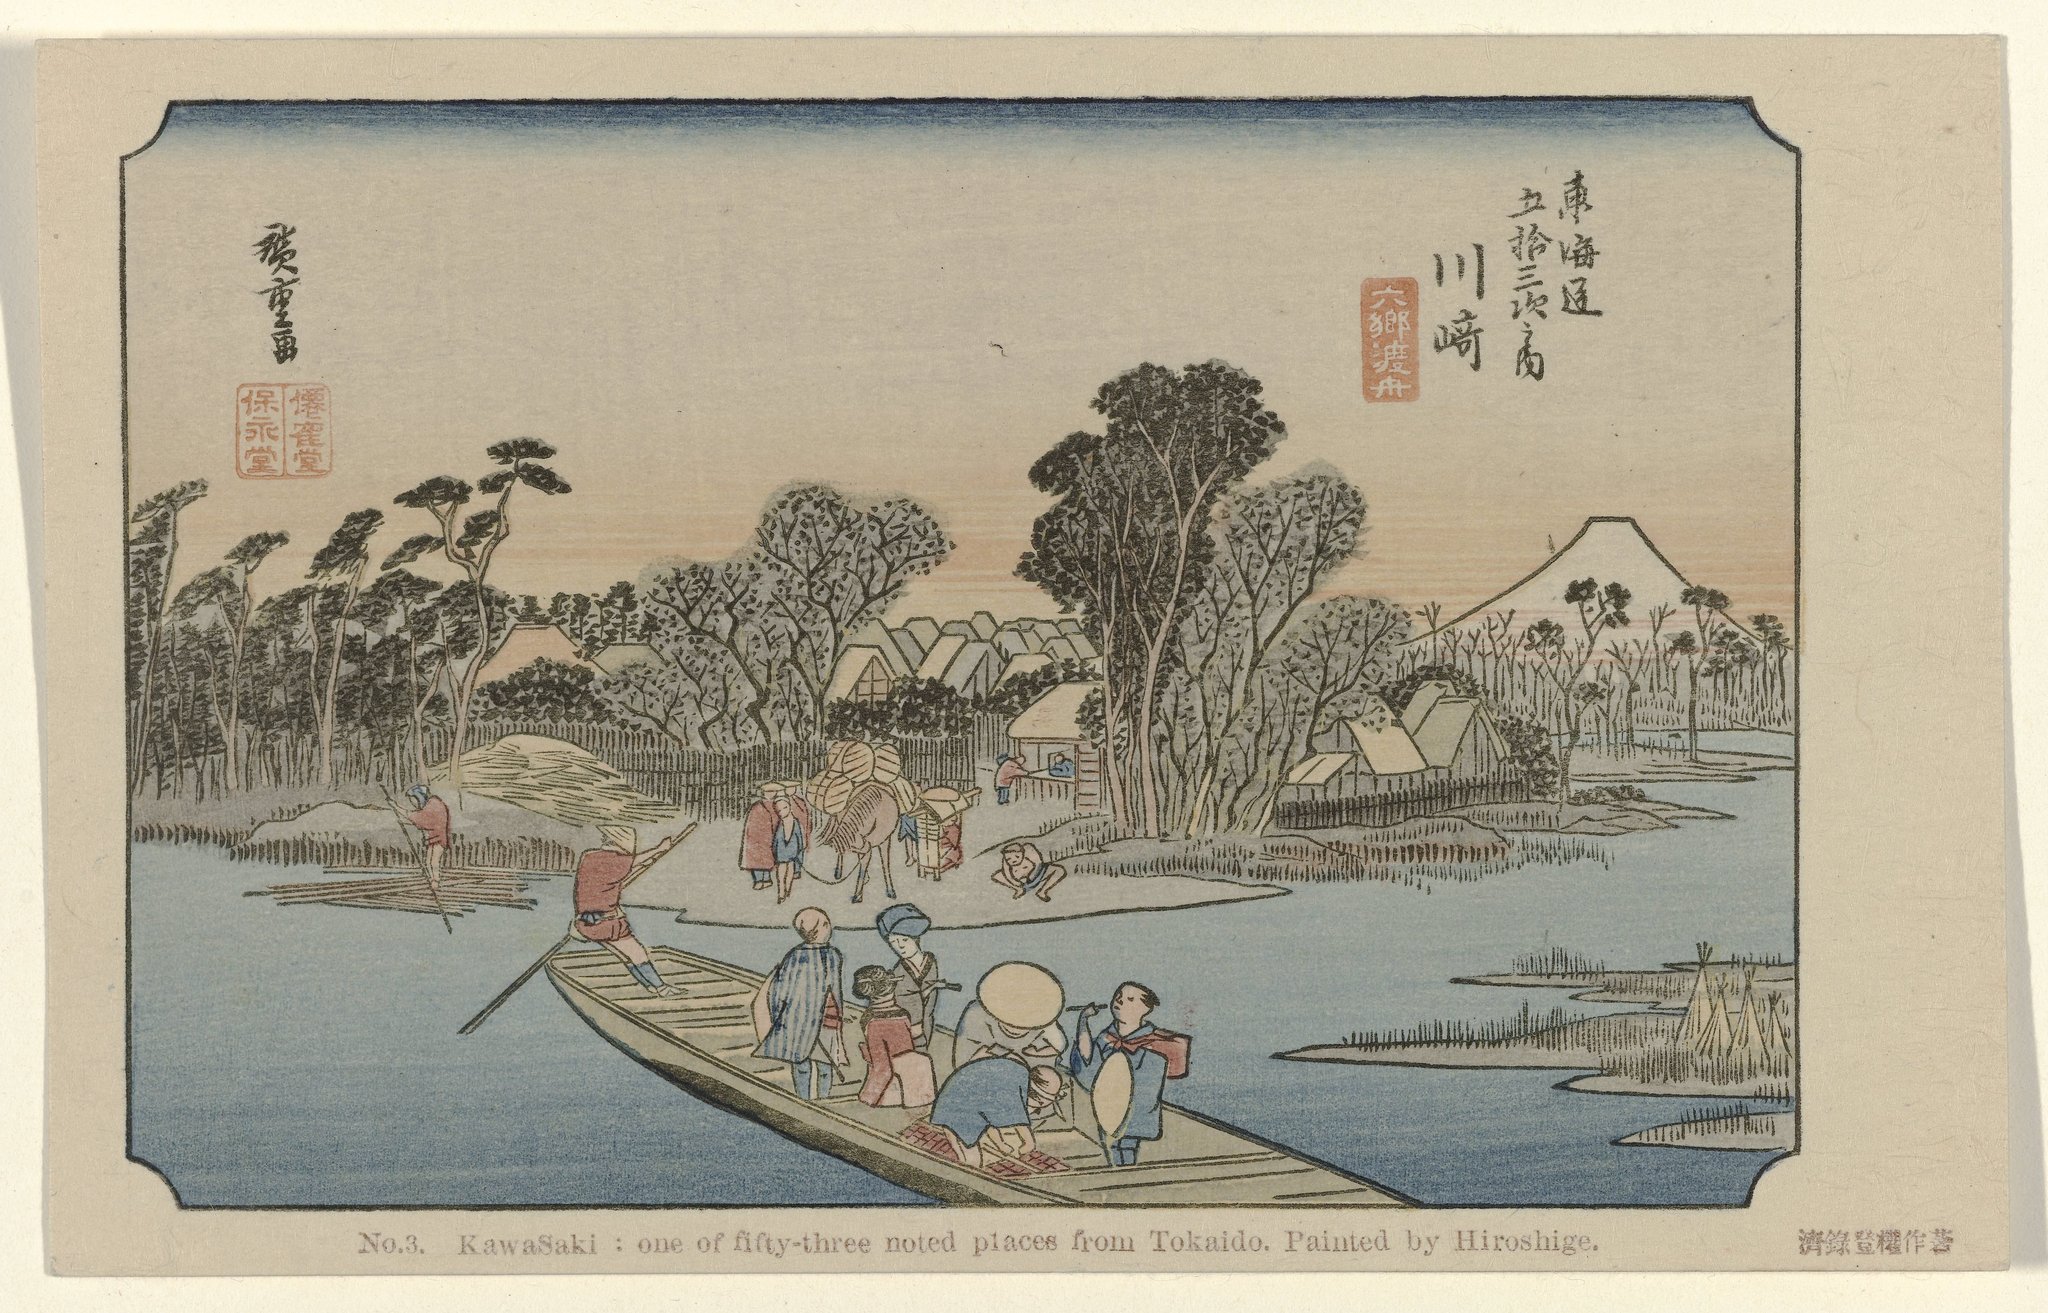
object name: ansichtkaart, prentbriefkaart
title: No. 3. Kawasaki: one of the fifty-three noted places from Tokaido. Painted by Hiroshige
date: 1906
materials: cardboard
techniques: woodcut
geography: japan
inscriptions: date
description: Het veerpontje bij Kawasaki vervoert reizigers naar de overkant, de berg Fuji in de verte.